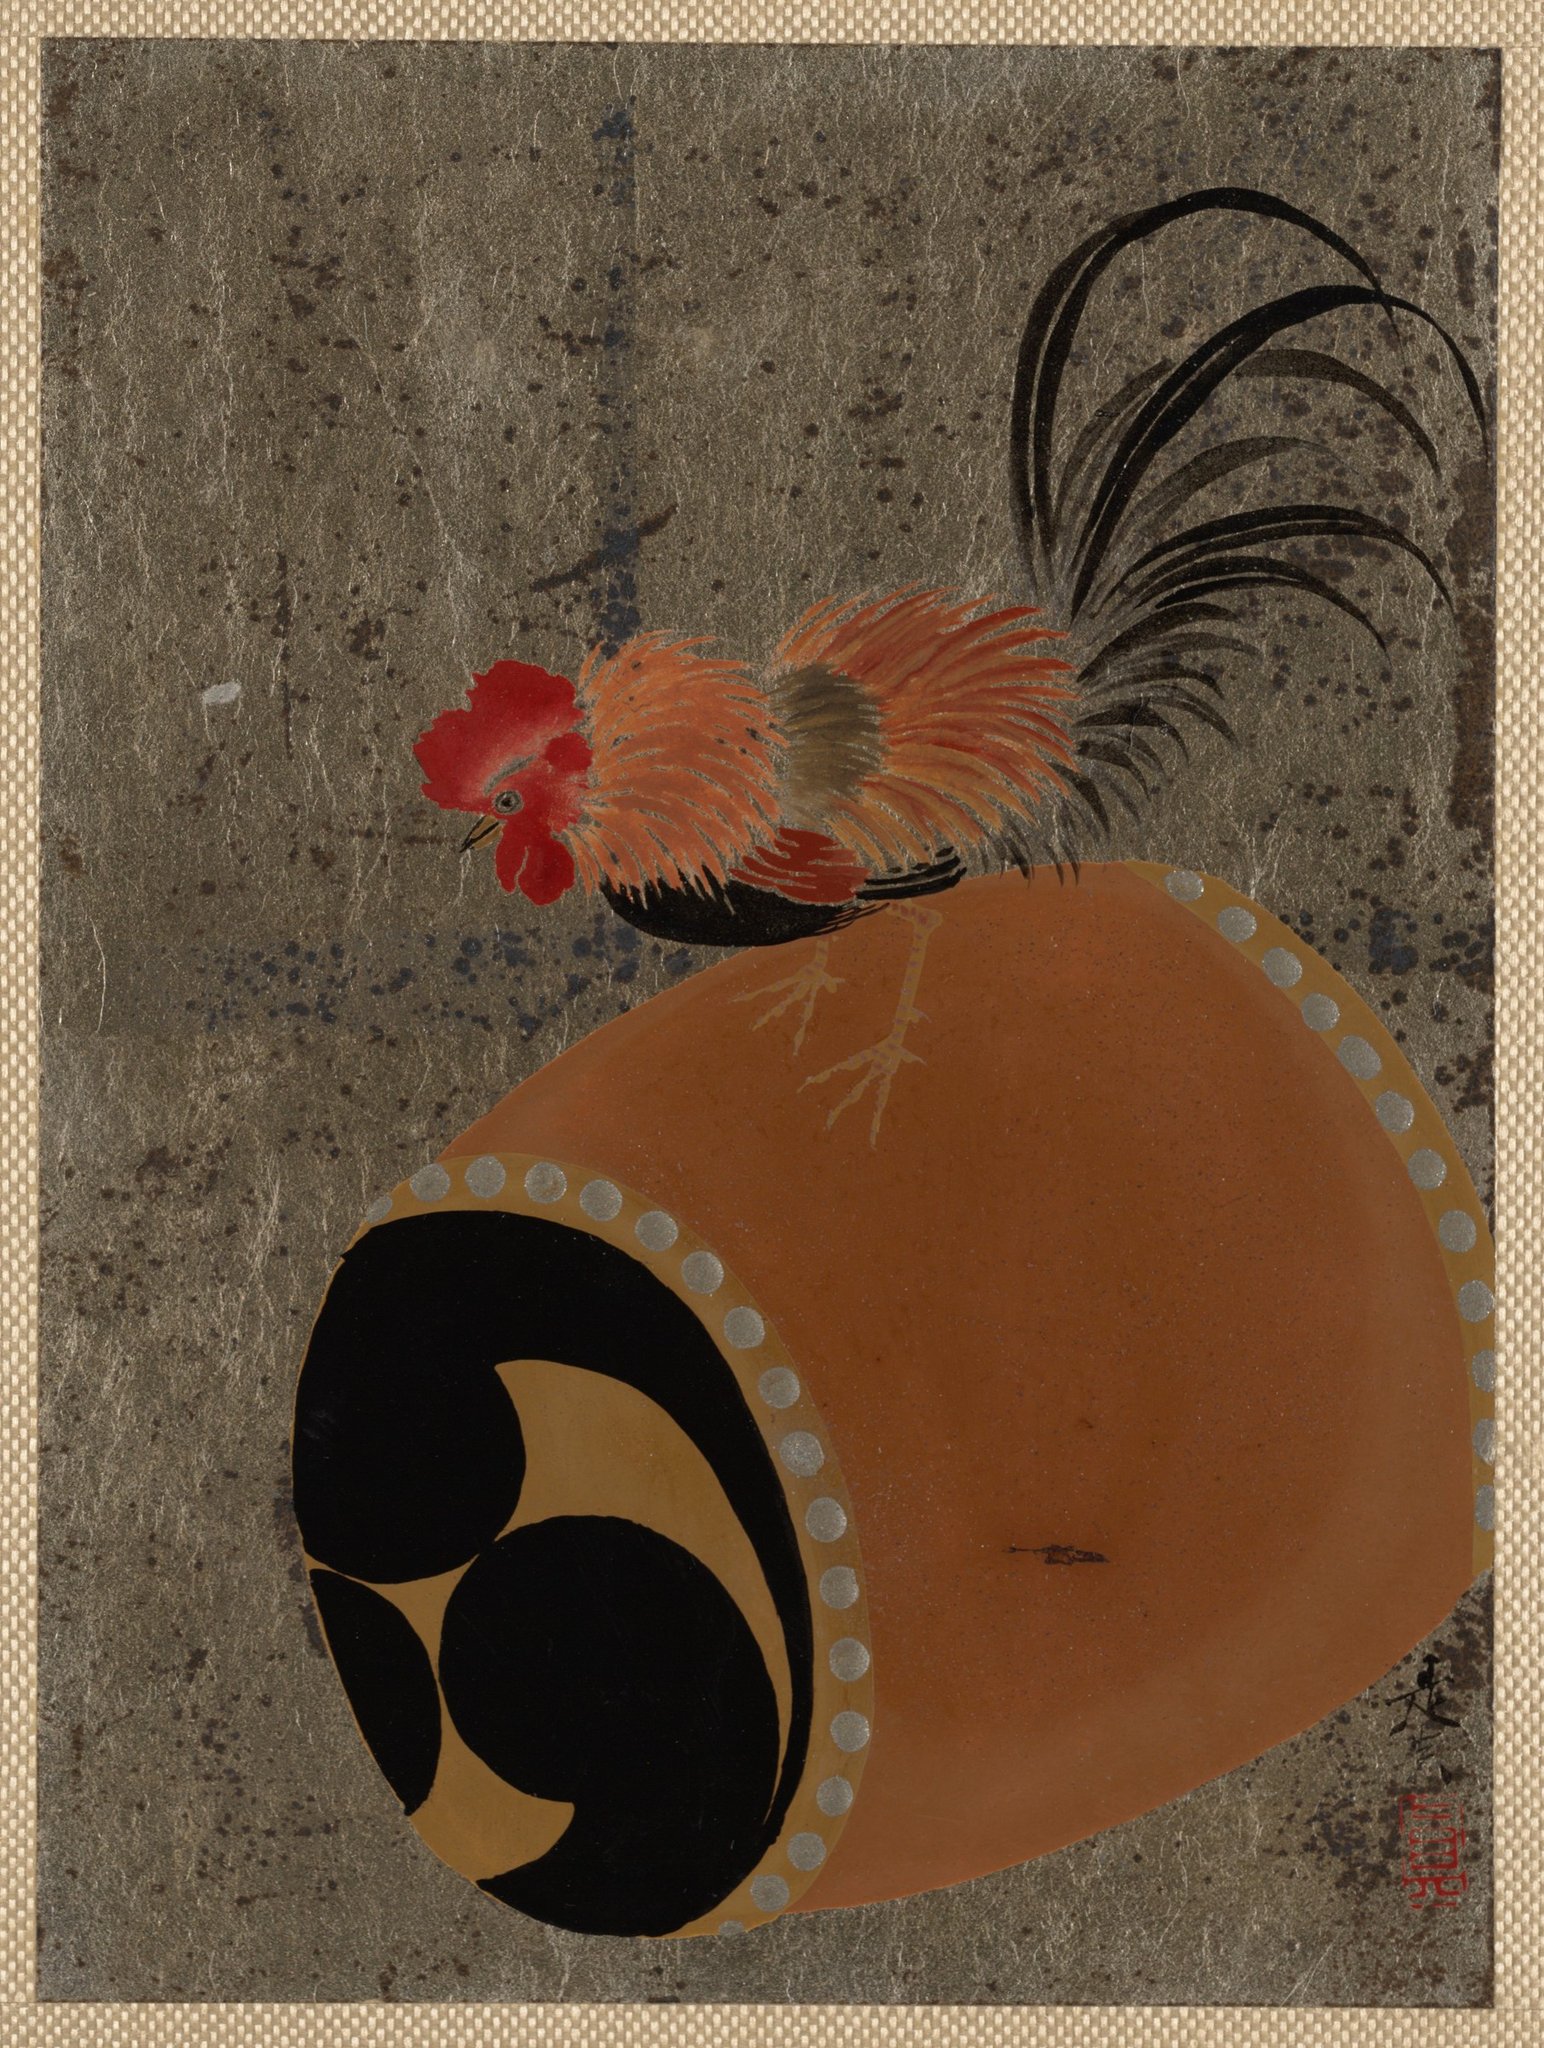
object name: album leaf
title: Cock on Drum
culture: japanese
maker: shibata zeshin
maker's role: artist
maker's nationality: japanese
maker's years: 1807-1891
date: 1882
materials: lacquer, paper, silver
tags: drums,roosters